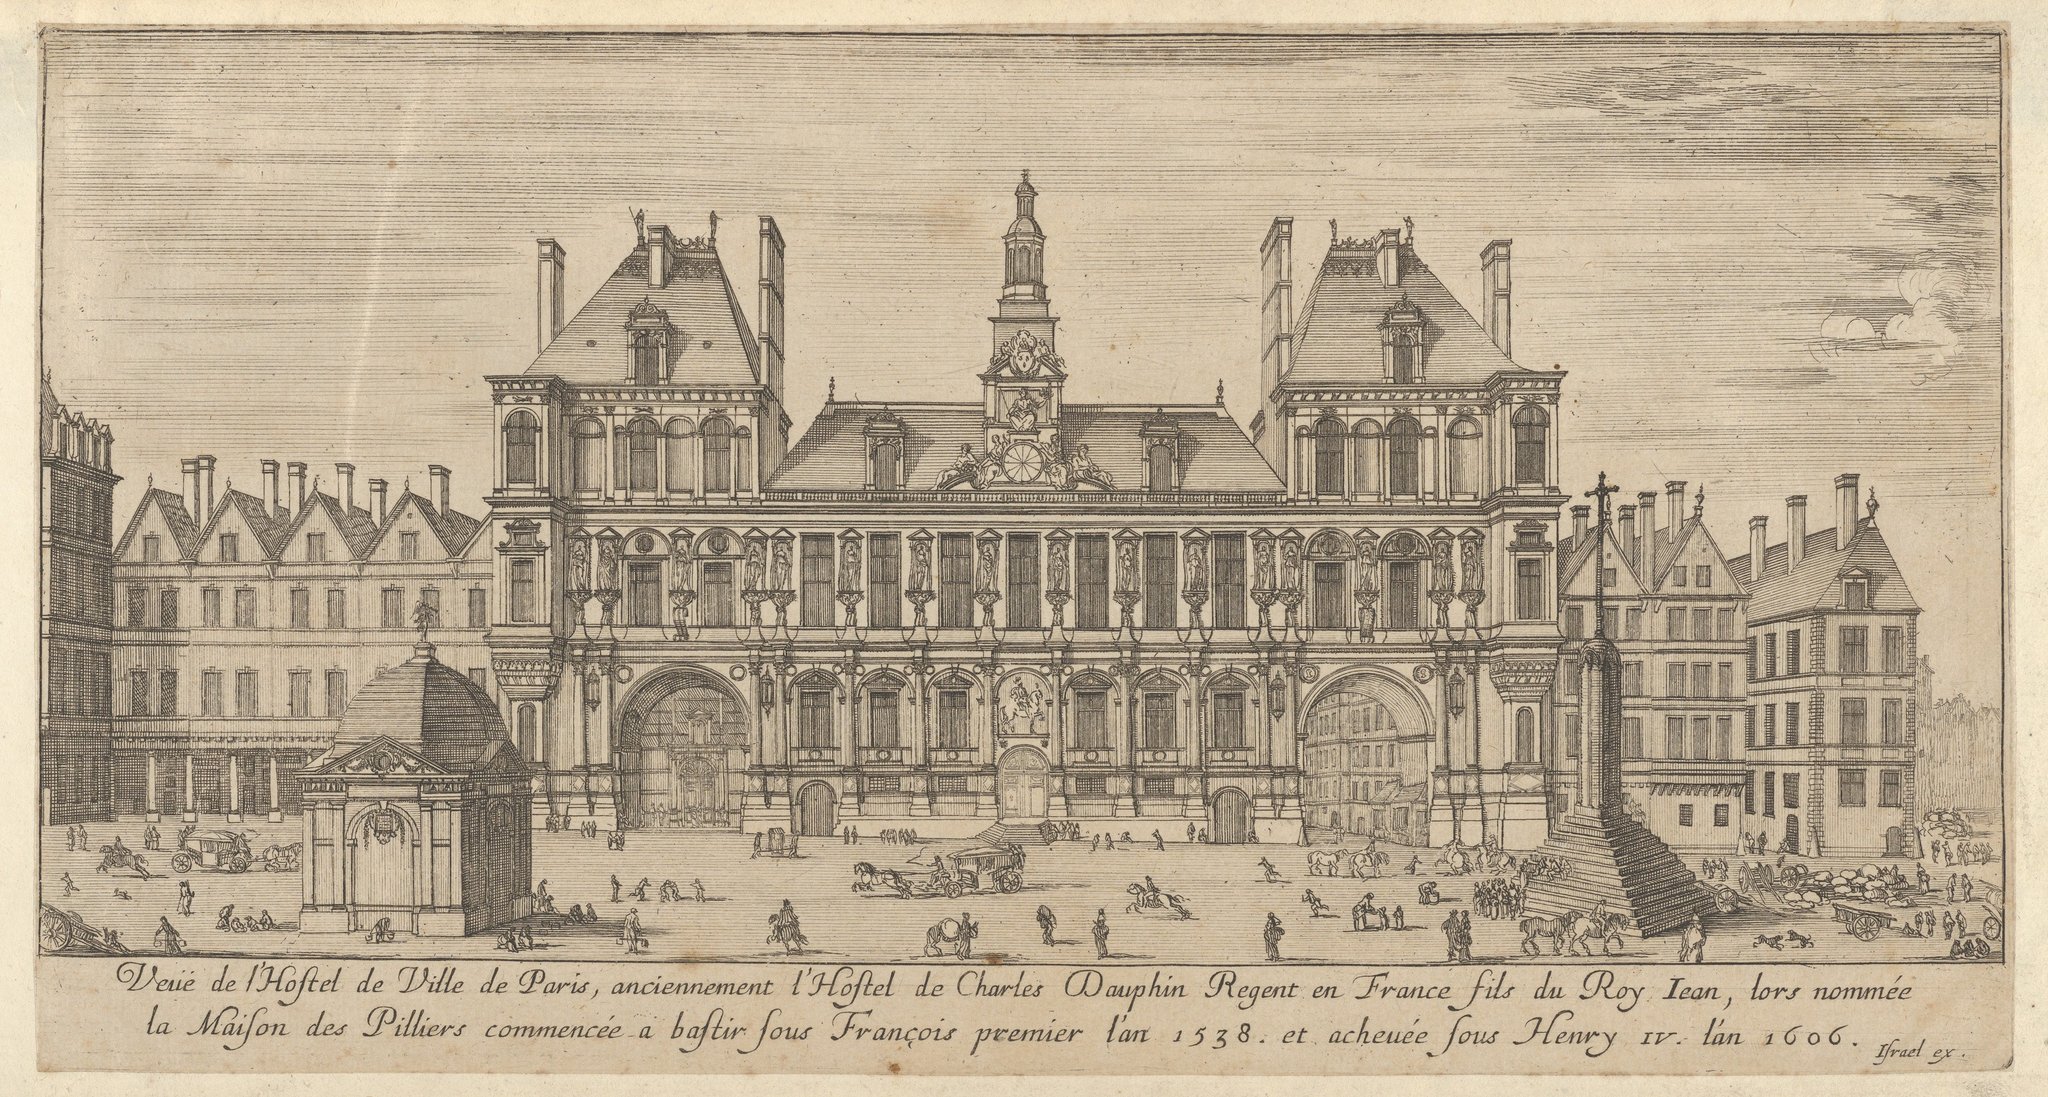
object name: print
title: View of the façade of the Hôtel de Ville, Paris, in the foreground a cross on a stepped platform and a freestanding domed building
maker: israël silvestre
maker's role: artist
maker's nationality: french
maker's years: 1621-1691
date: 1636-1691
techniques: etching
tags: architecture,buildings,paris